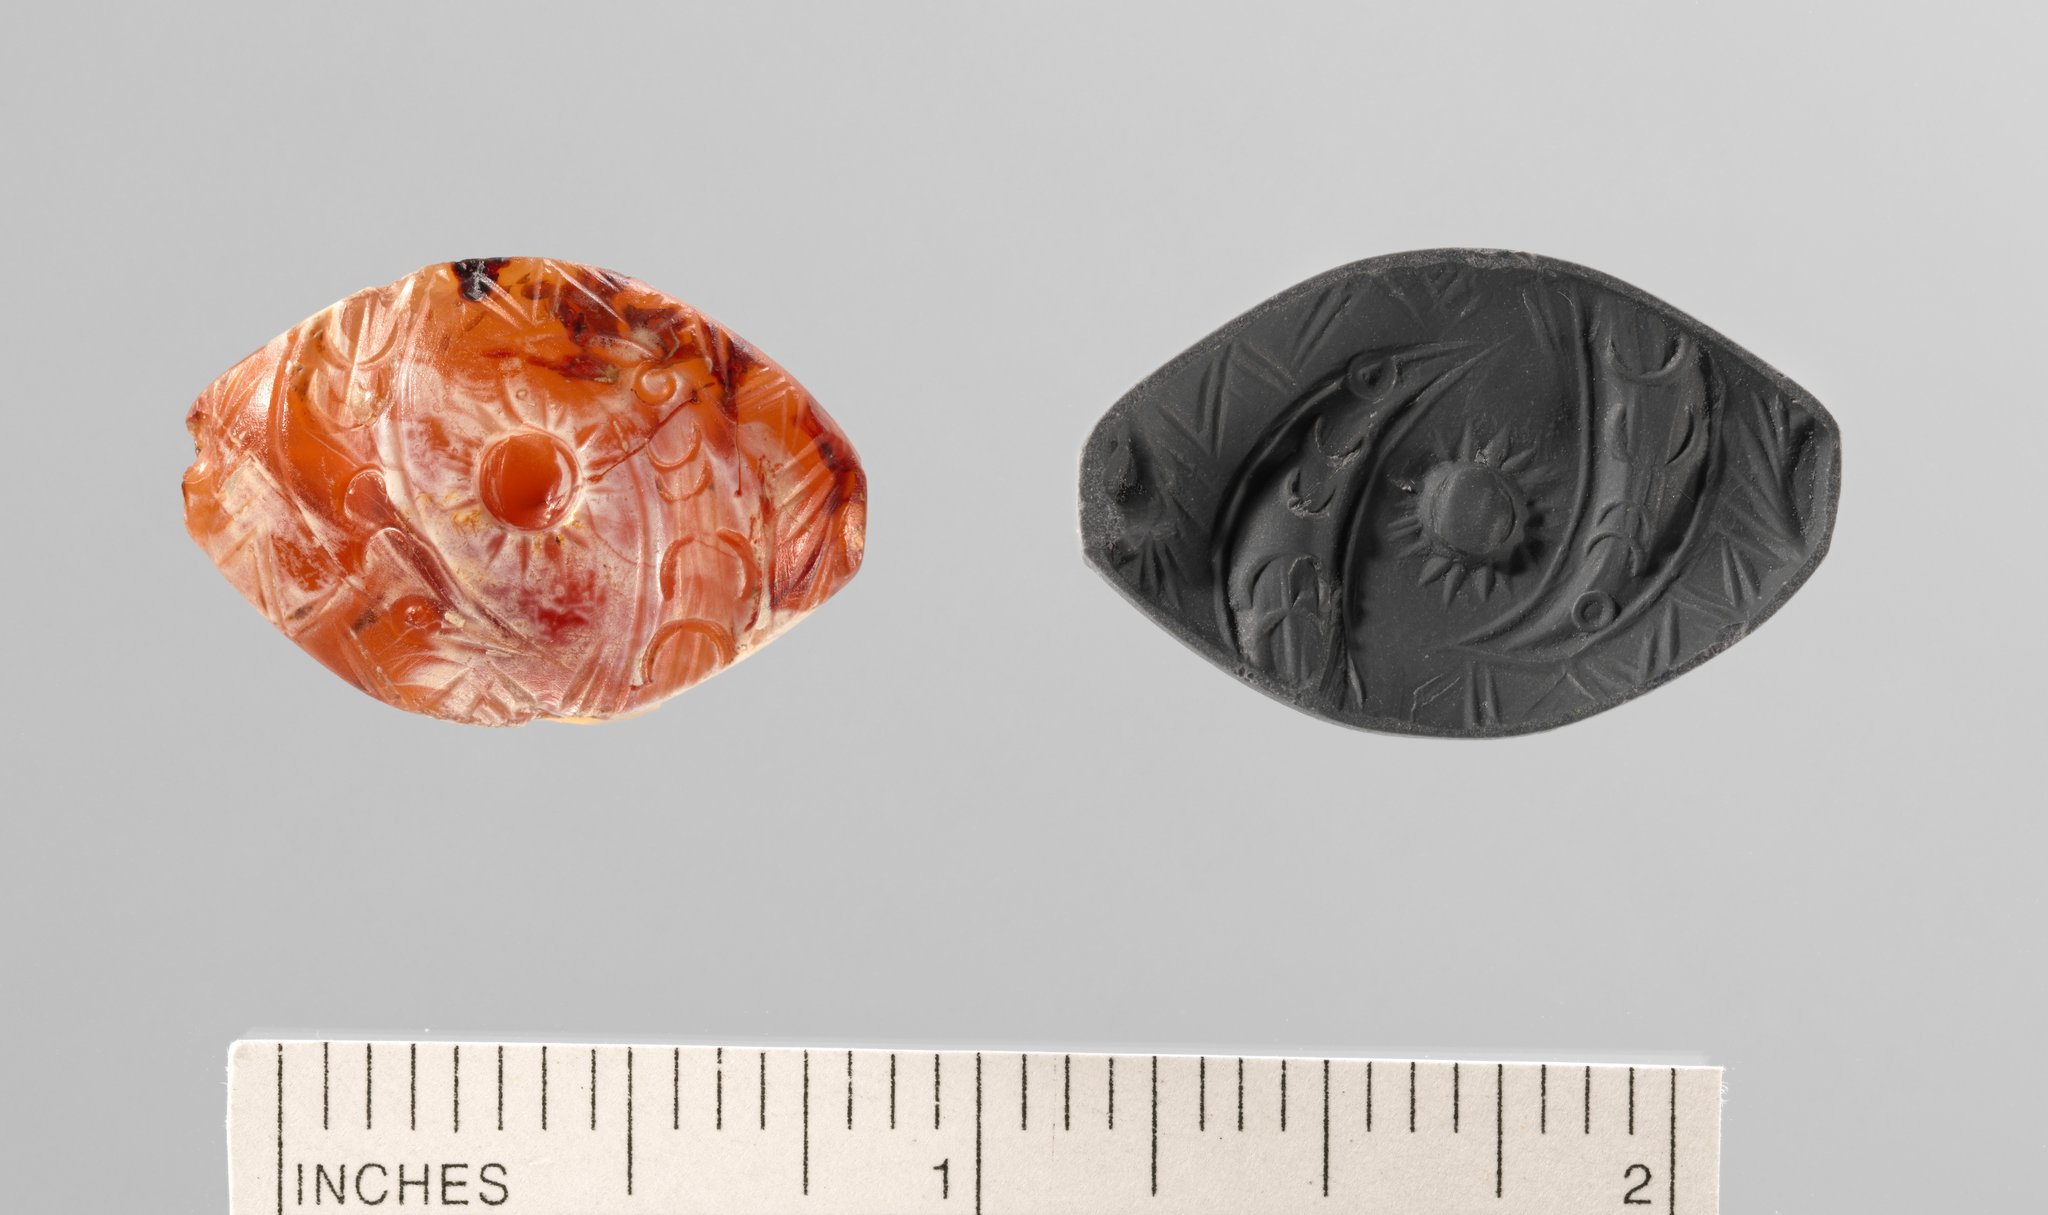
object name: seal, carinated amygdaloid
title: Carnelian Carinated Amygdaloid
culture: minoan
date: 1650-1500 BCE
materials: gemstone